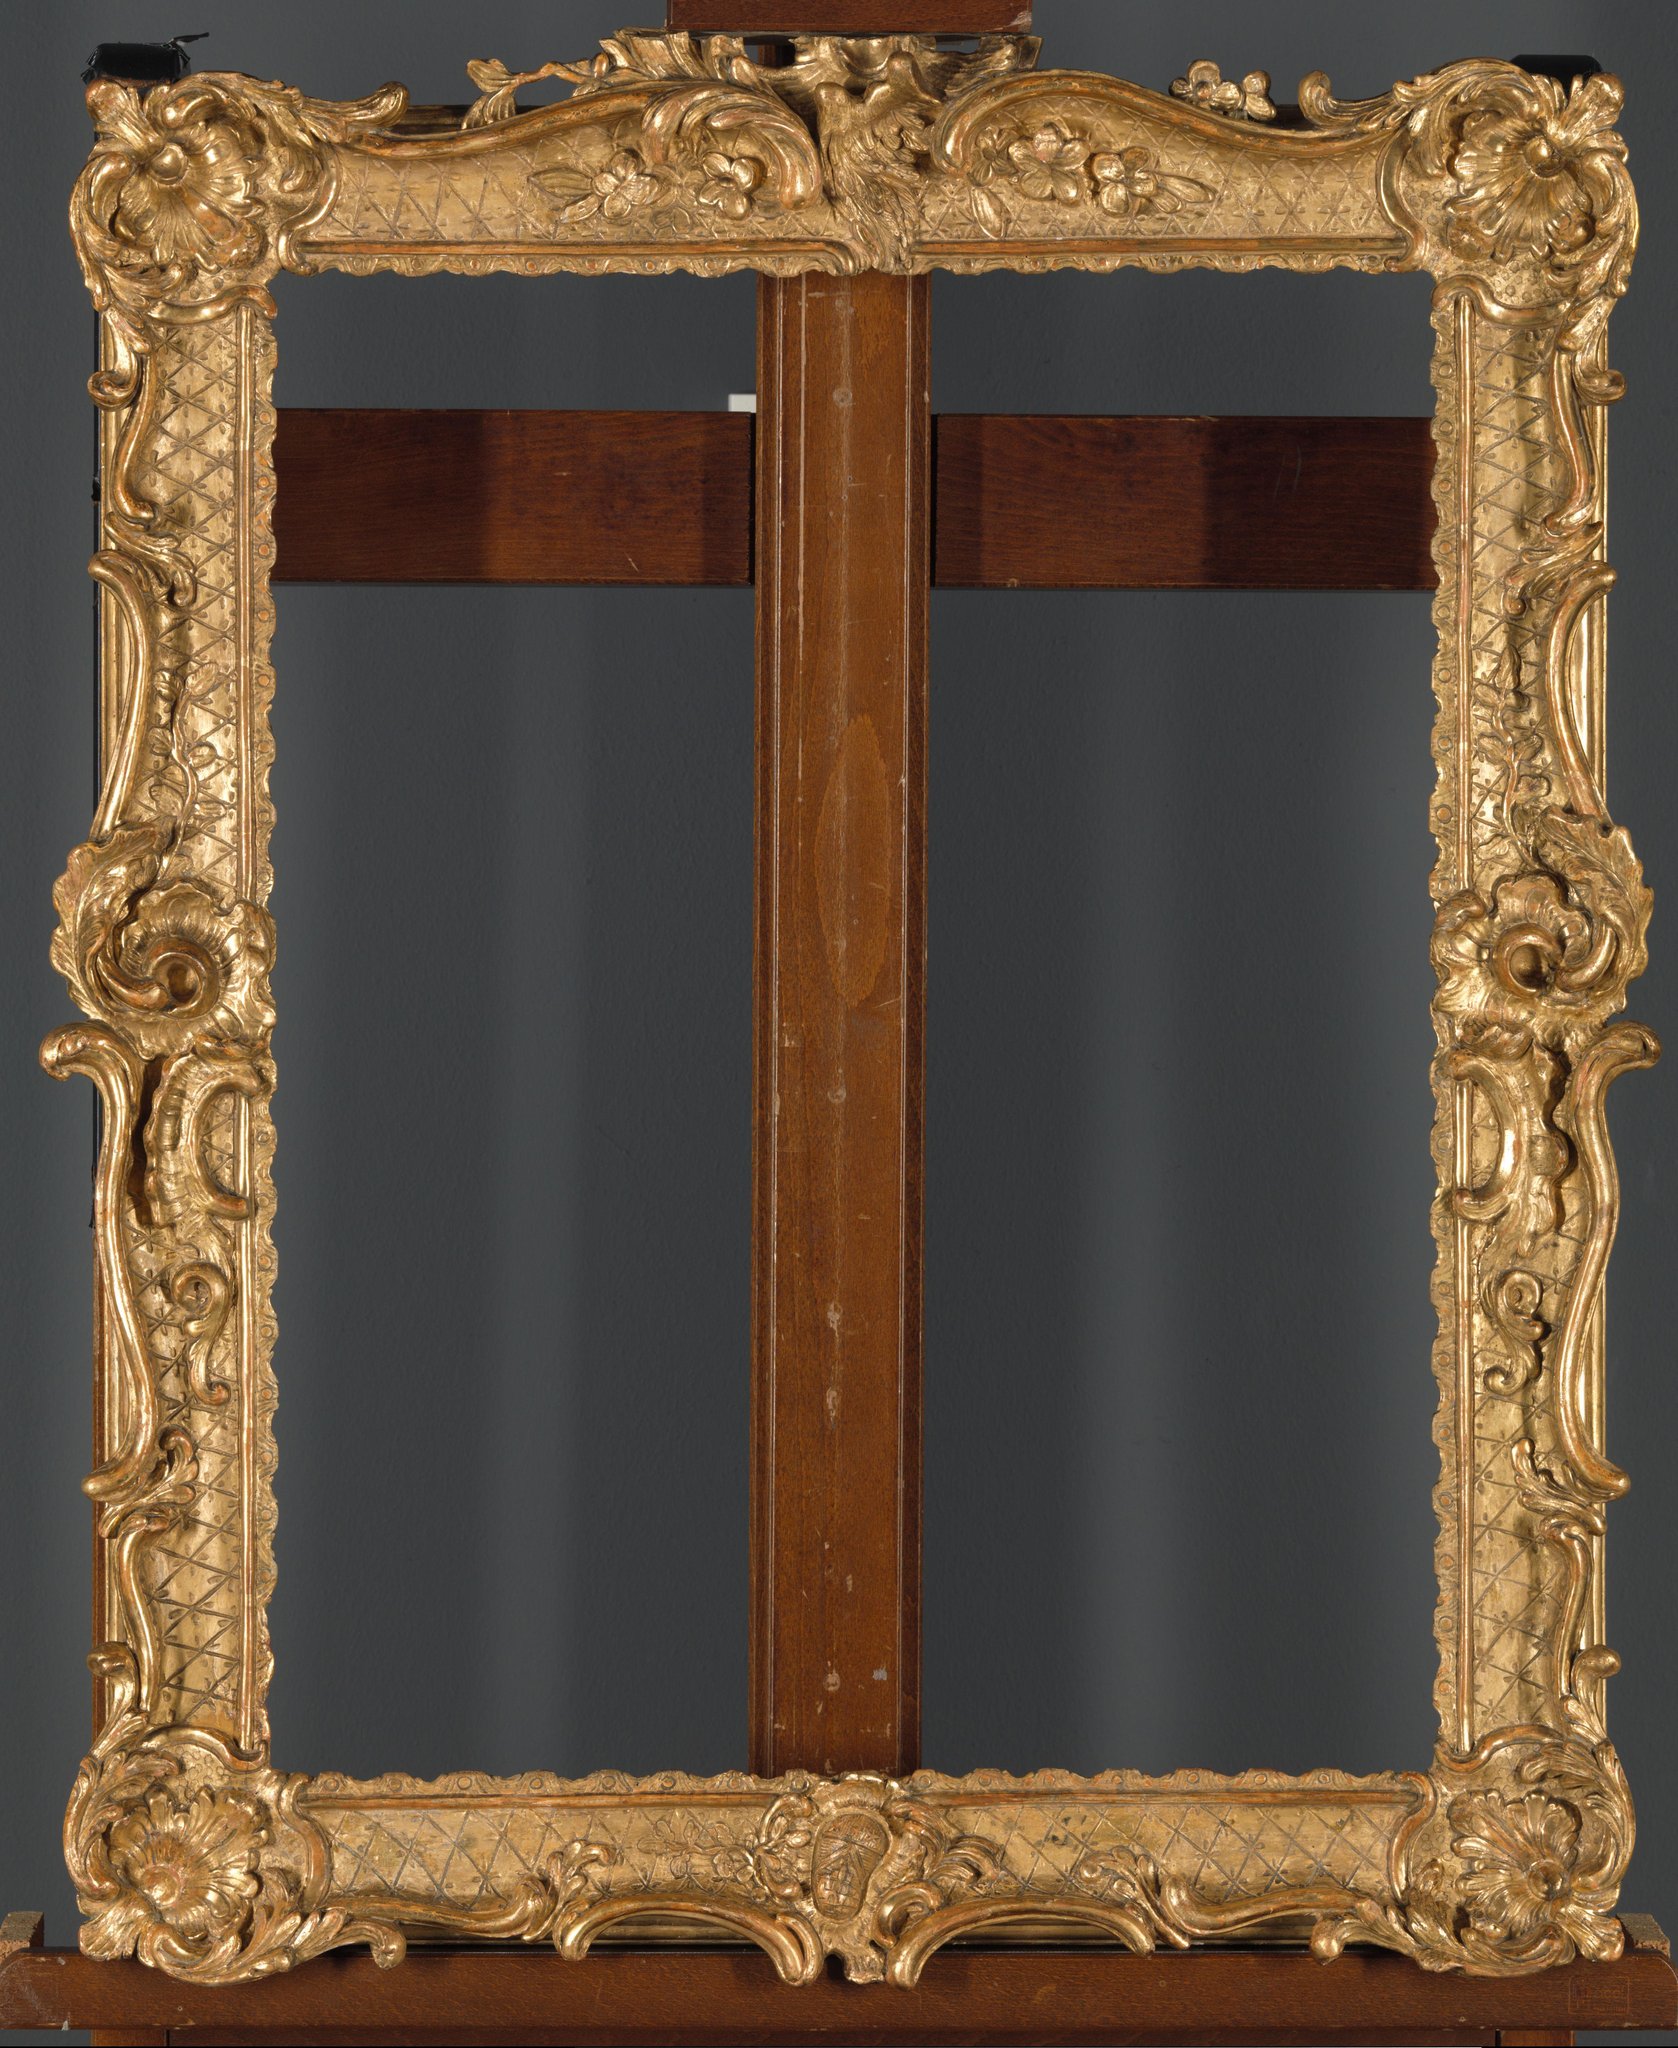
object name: frame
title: Gesneden en vergulde lijst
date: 1740-1750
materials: wood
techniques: gilding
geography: switzerland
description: Gesneden en vergulde lijst in Rococo-stijl. Decoratieve bekroning ontbreekt. De gedeeltelijk matte en gedeeltelijk glanzende vergulding is oorspronkelijk.